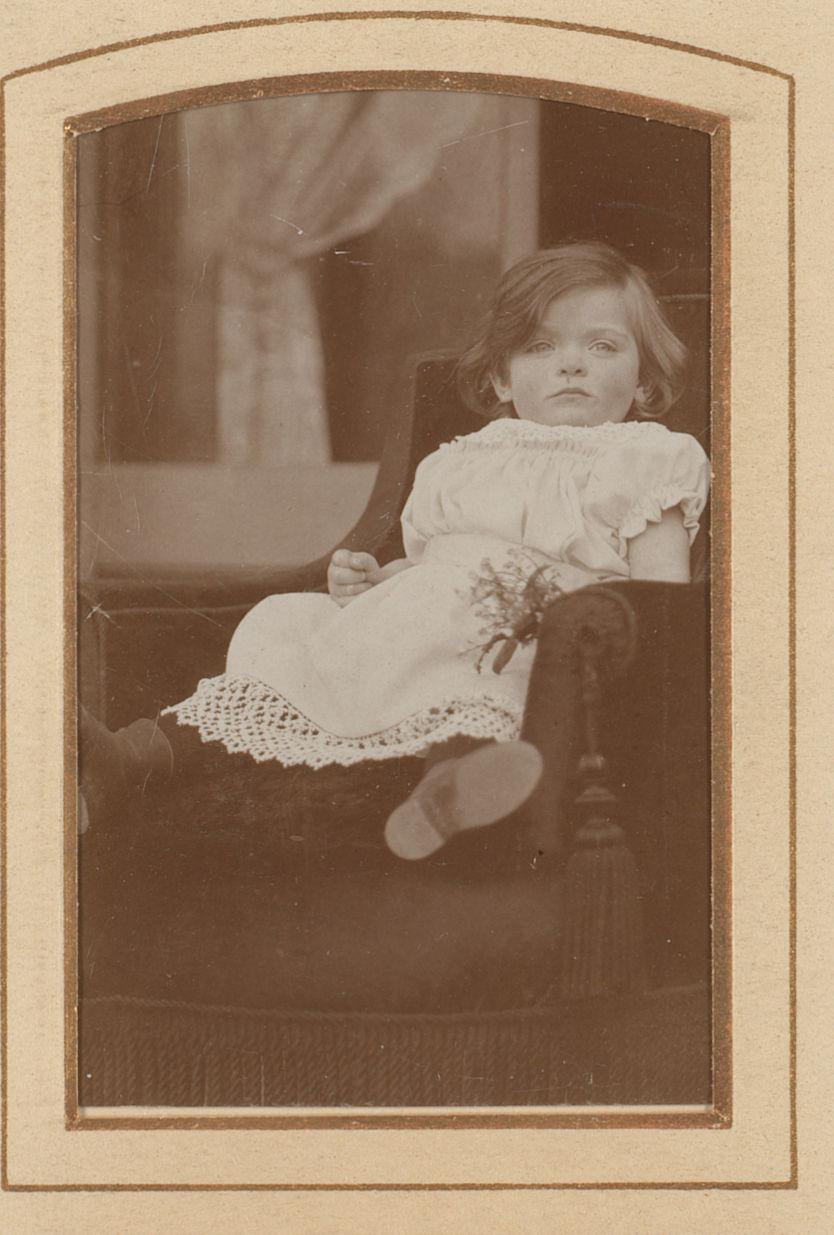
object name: album leaf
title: Portret van een meisje, zittend in een stoel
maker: Anonymous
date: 1890-1920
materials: cardboard, photographic support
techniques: collodion silver print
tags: girl (child between toddler and youth)